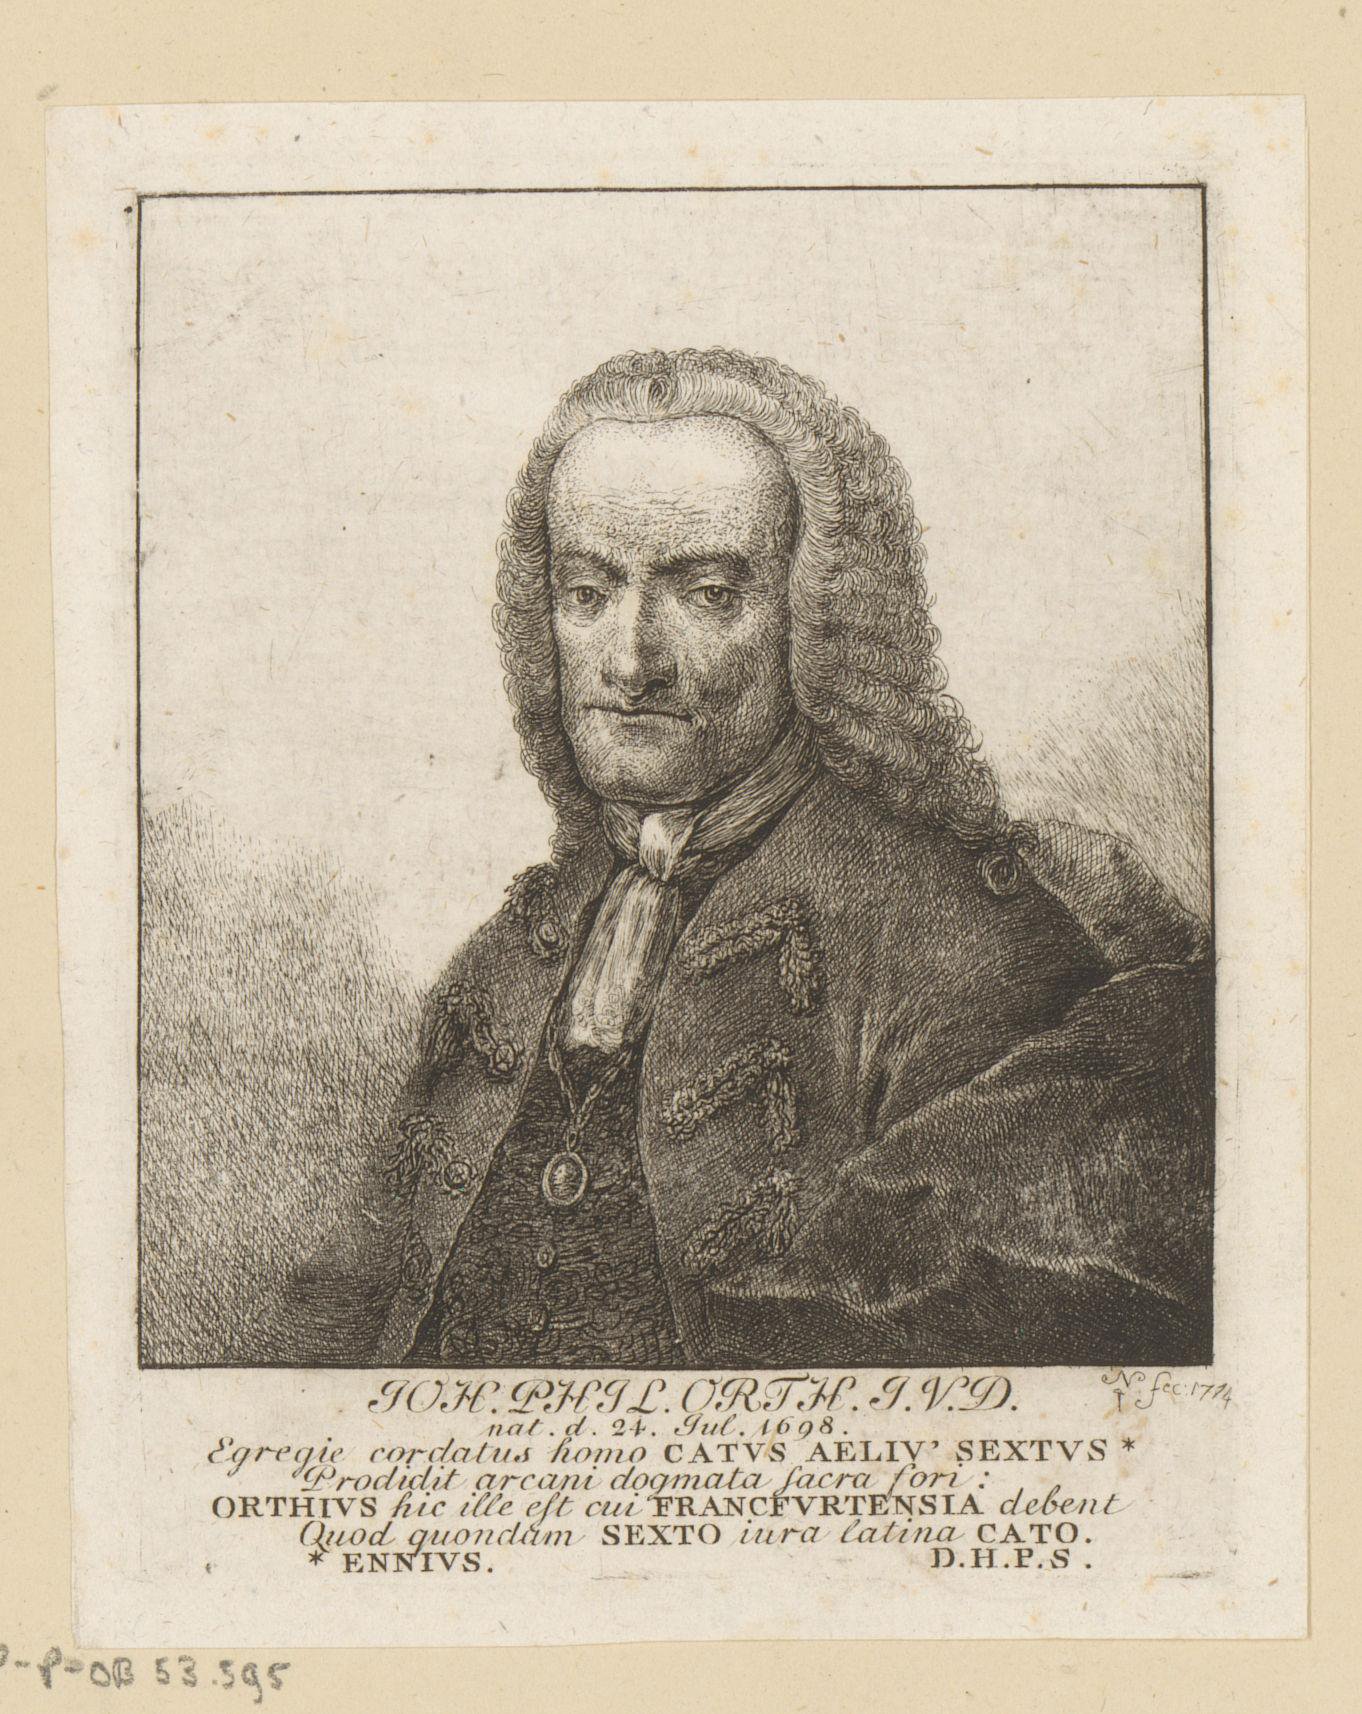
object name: print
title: Portret van Johann Philipp Orth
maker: johann andreas benjamin nothnagel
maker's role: print maker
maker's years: 1729-1804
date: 1774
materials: paper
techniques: etching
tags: historical persons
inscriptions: collector's mark: Lugt 240